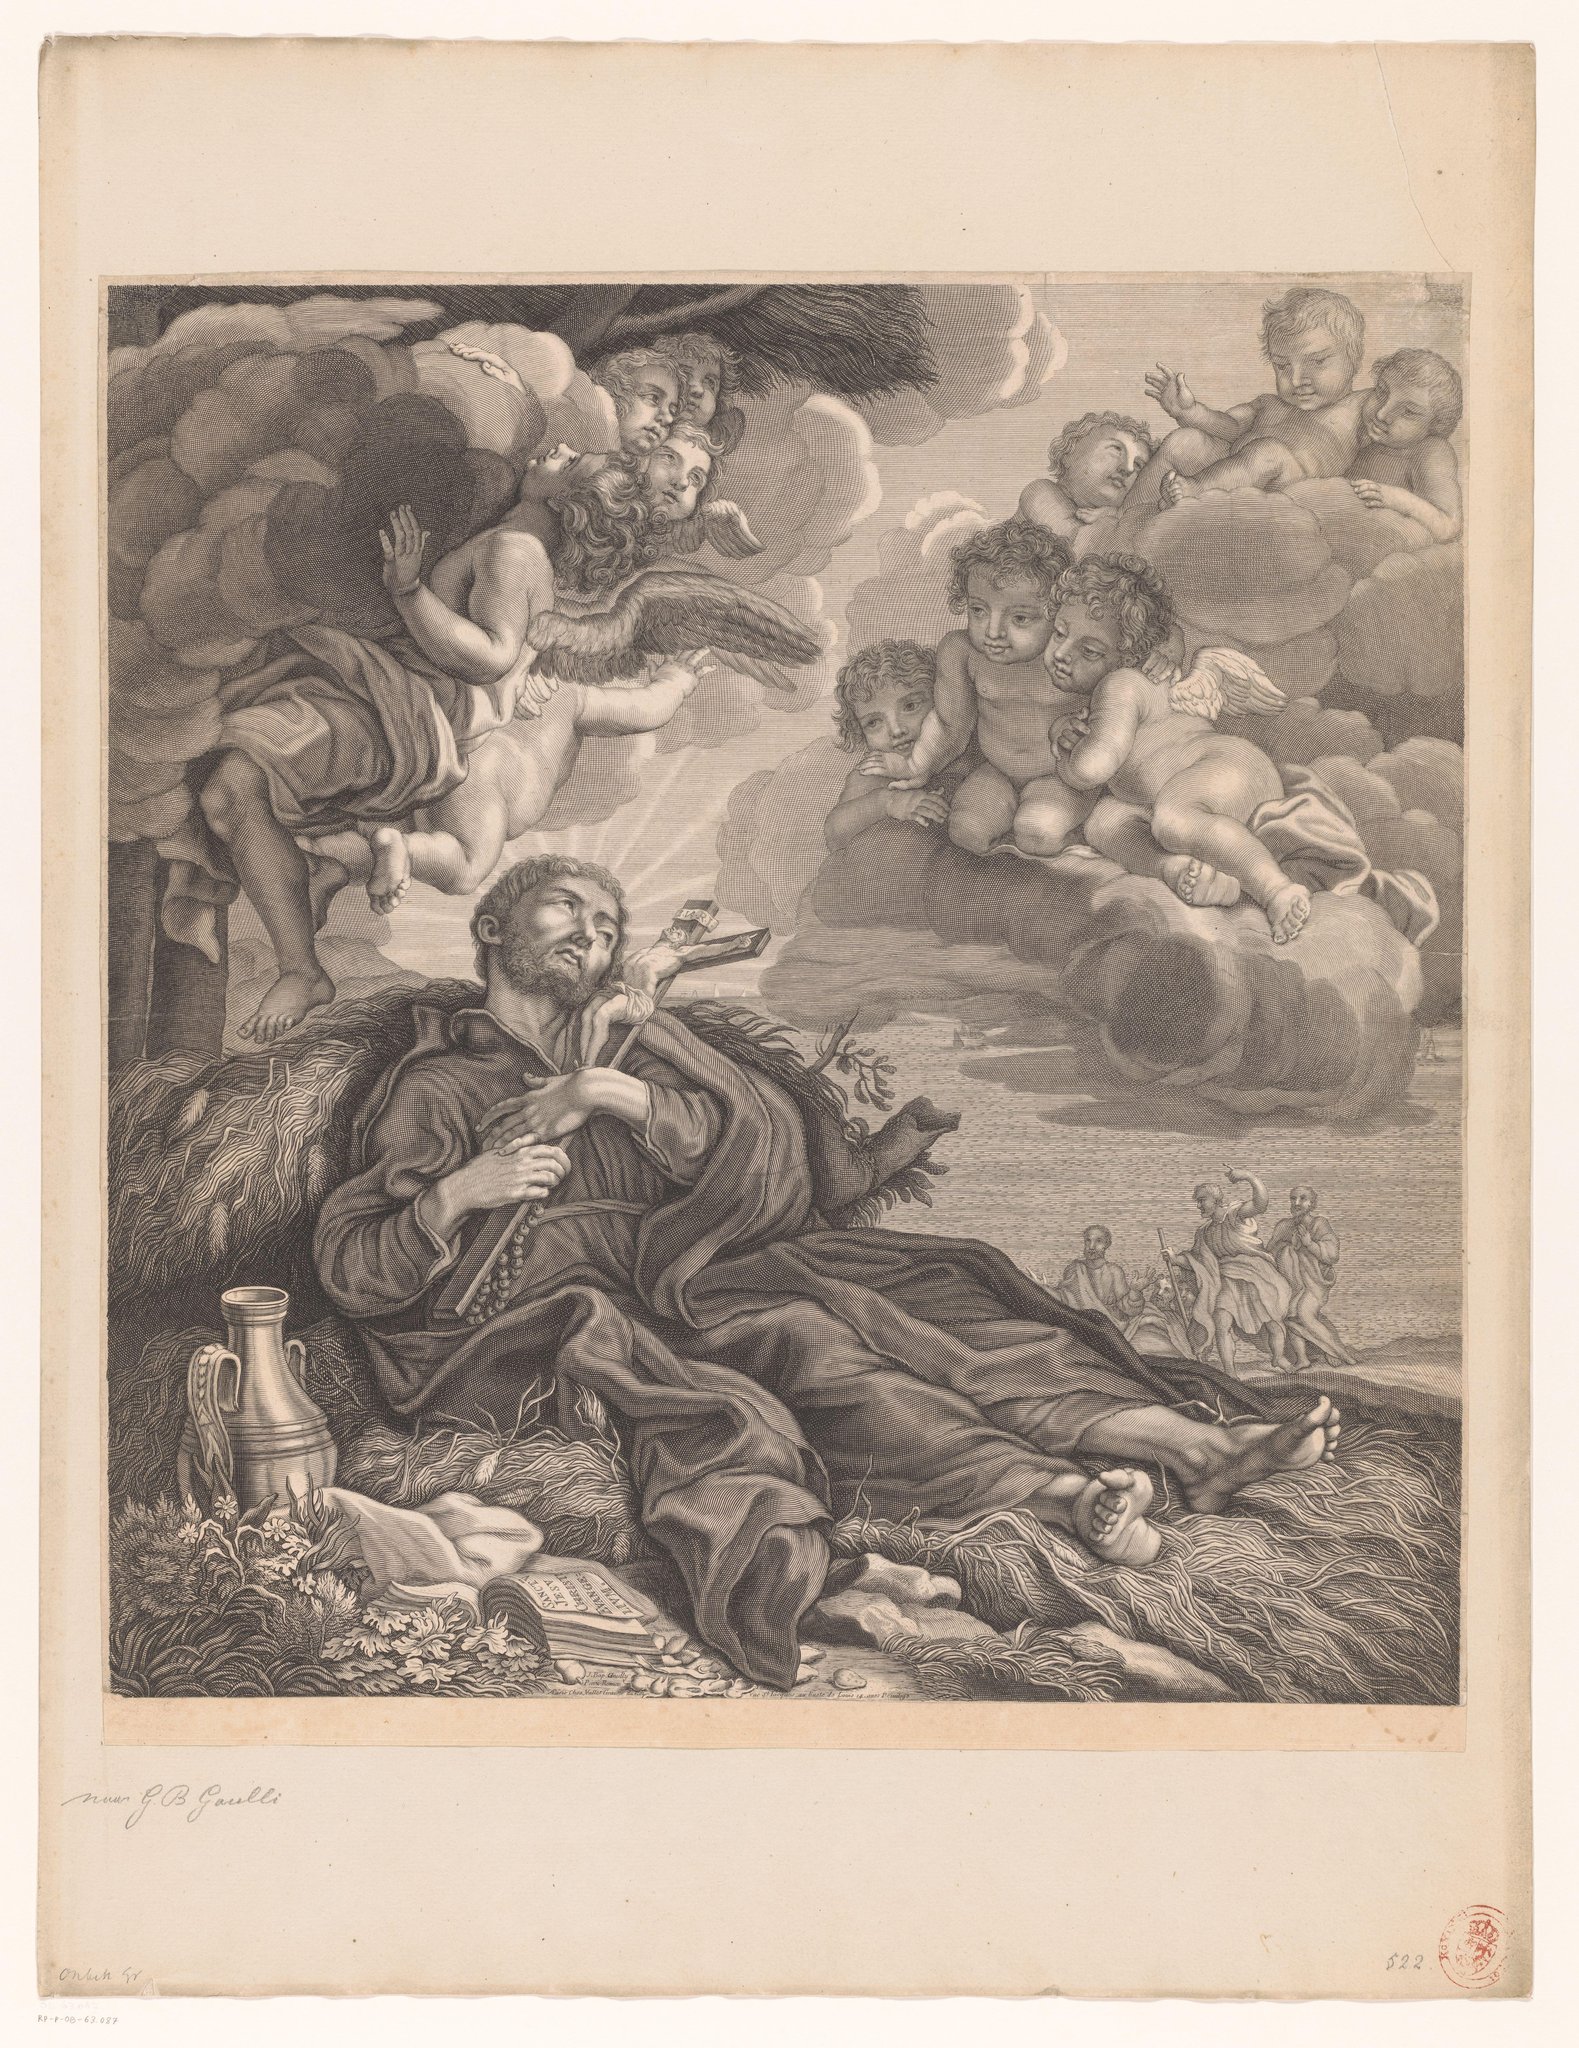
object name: print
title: H. Franciscus Xaverius met kruisbeeld in het stro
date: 1672-1709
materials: paper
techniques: engraving, etching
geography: paris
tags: the jesuit missionary francis xavier; possible attributes: cross, crucifix, flaming heart, indian, lily, torch (+ angel(s))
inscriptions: collector's mark: Lugt 240